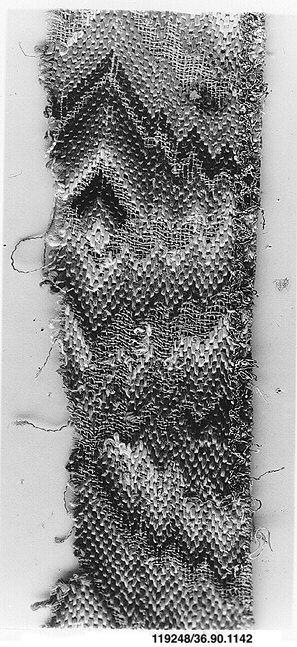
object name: piece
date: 1701-1800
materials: cotton, silk